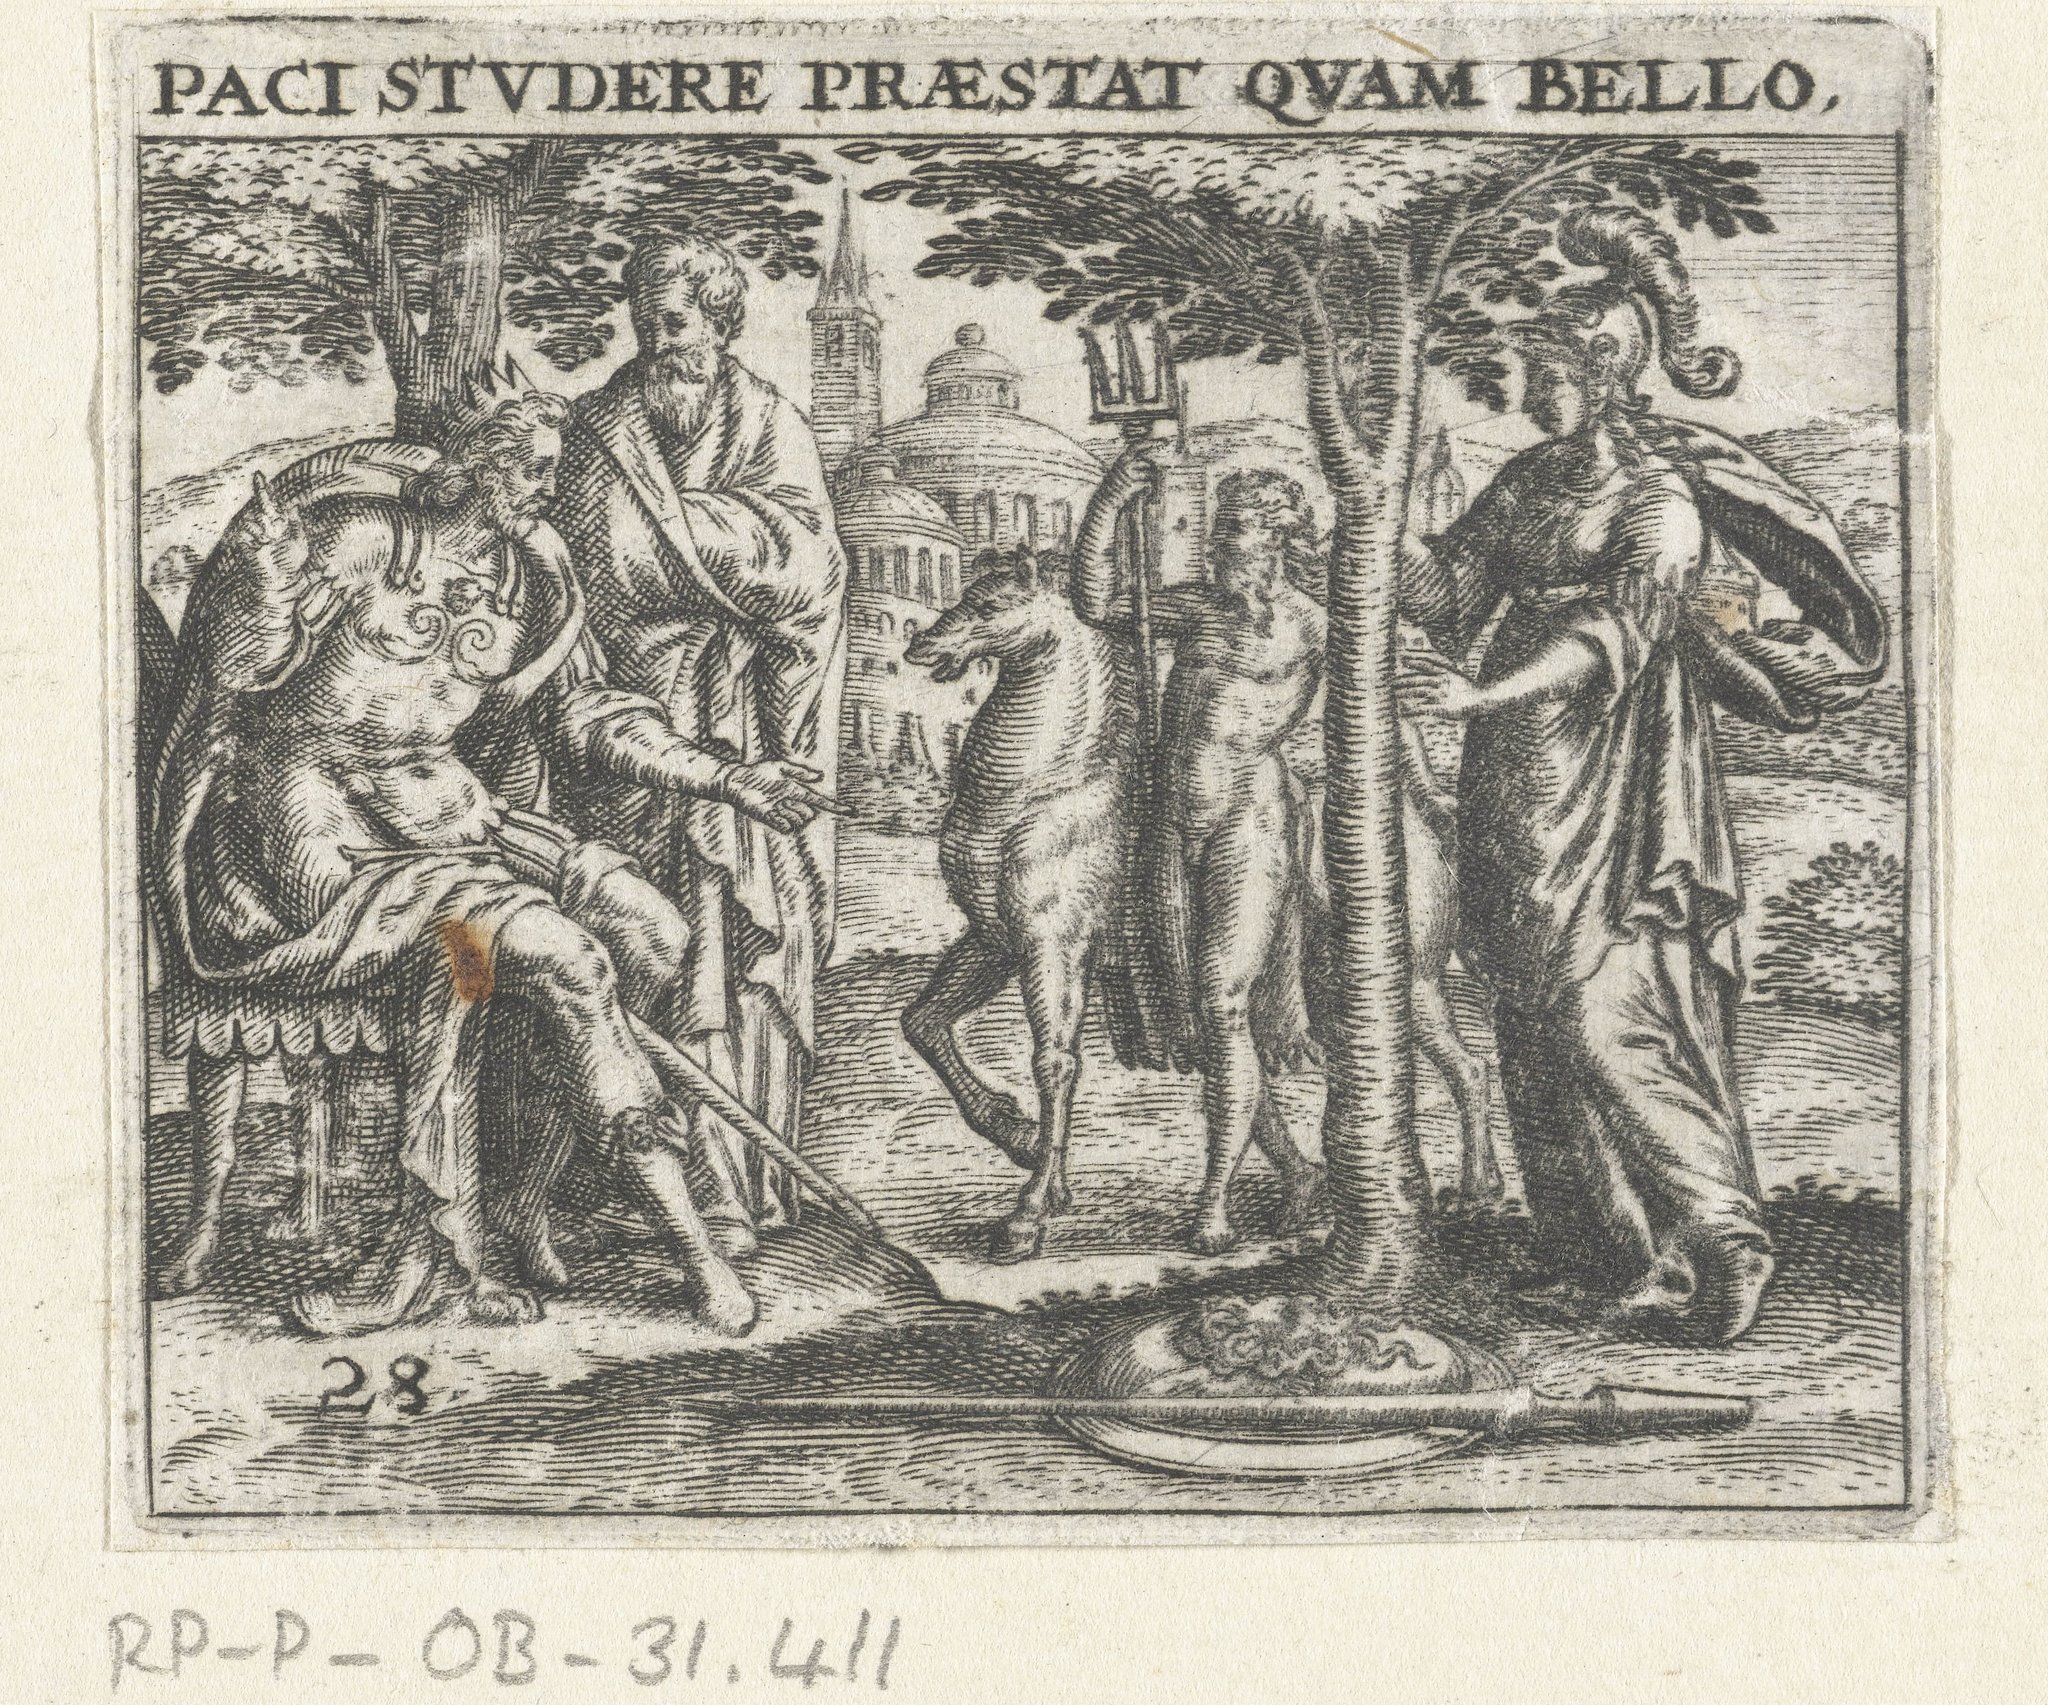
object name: book illustration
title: Denis Lebey de Batilly, Emblemata, 1596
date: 1596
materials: paper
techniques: engraving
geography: frankfurt am main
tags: (story of) minerva (pallas, athena), emperor, (story of) ulysses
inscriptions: collector's mark: Lugt 240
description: Een Romeinse keizer zit op een stoel onder bomen met een van zijn adviseurs naast zich. Minerva en Odysseus komen bij hem op bezoek en praten met hem.